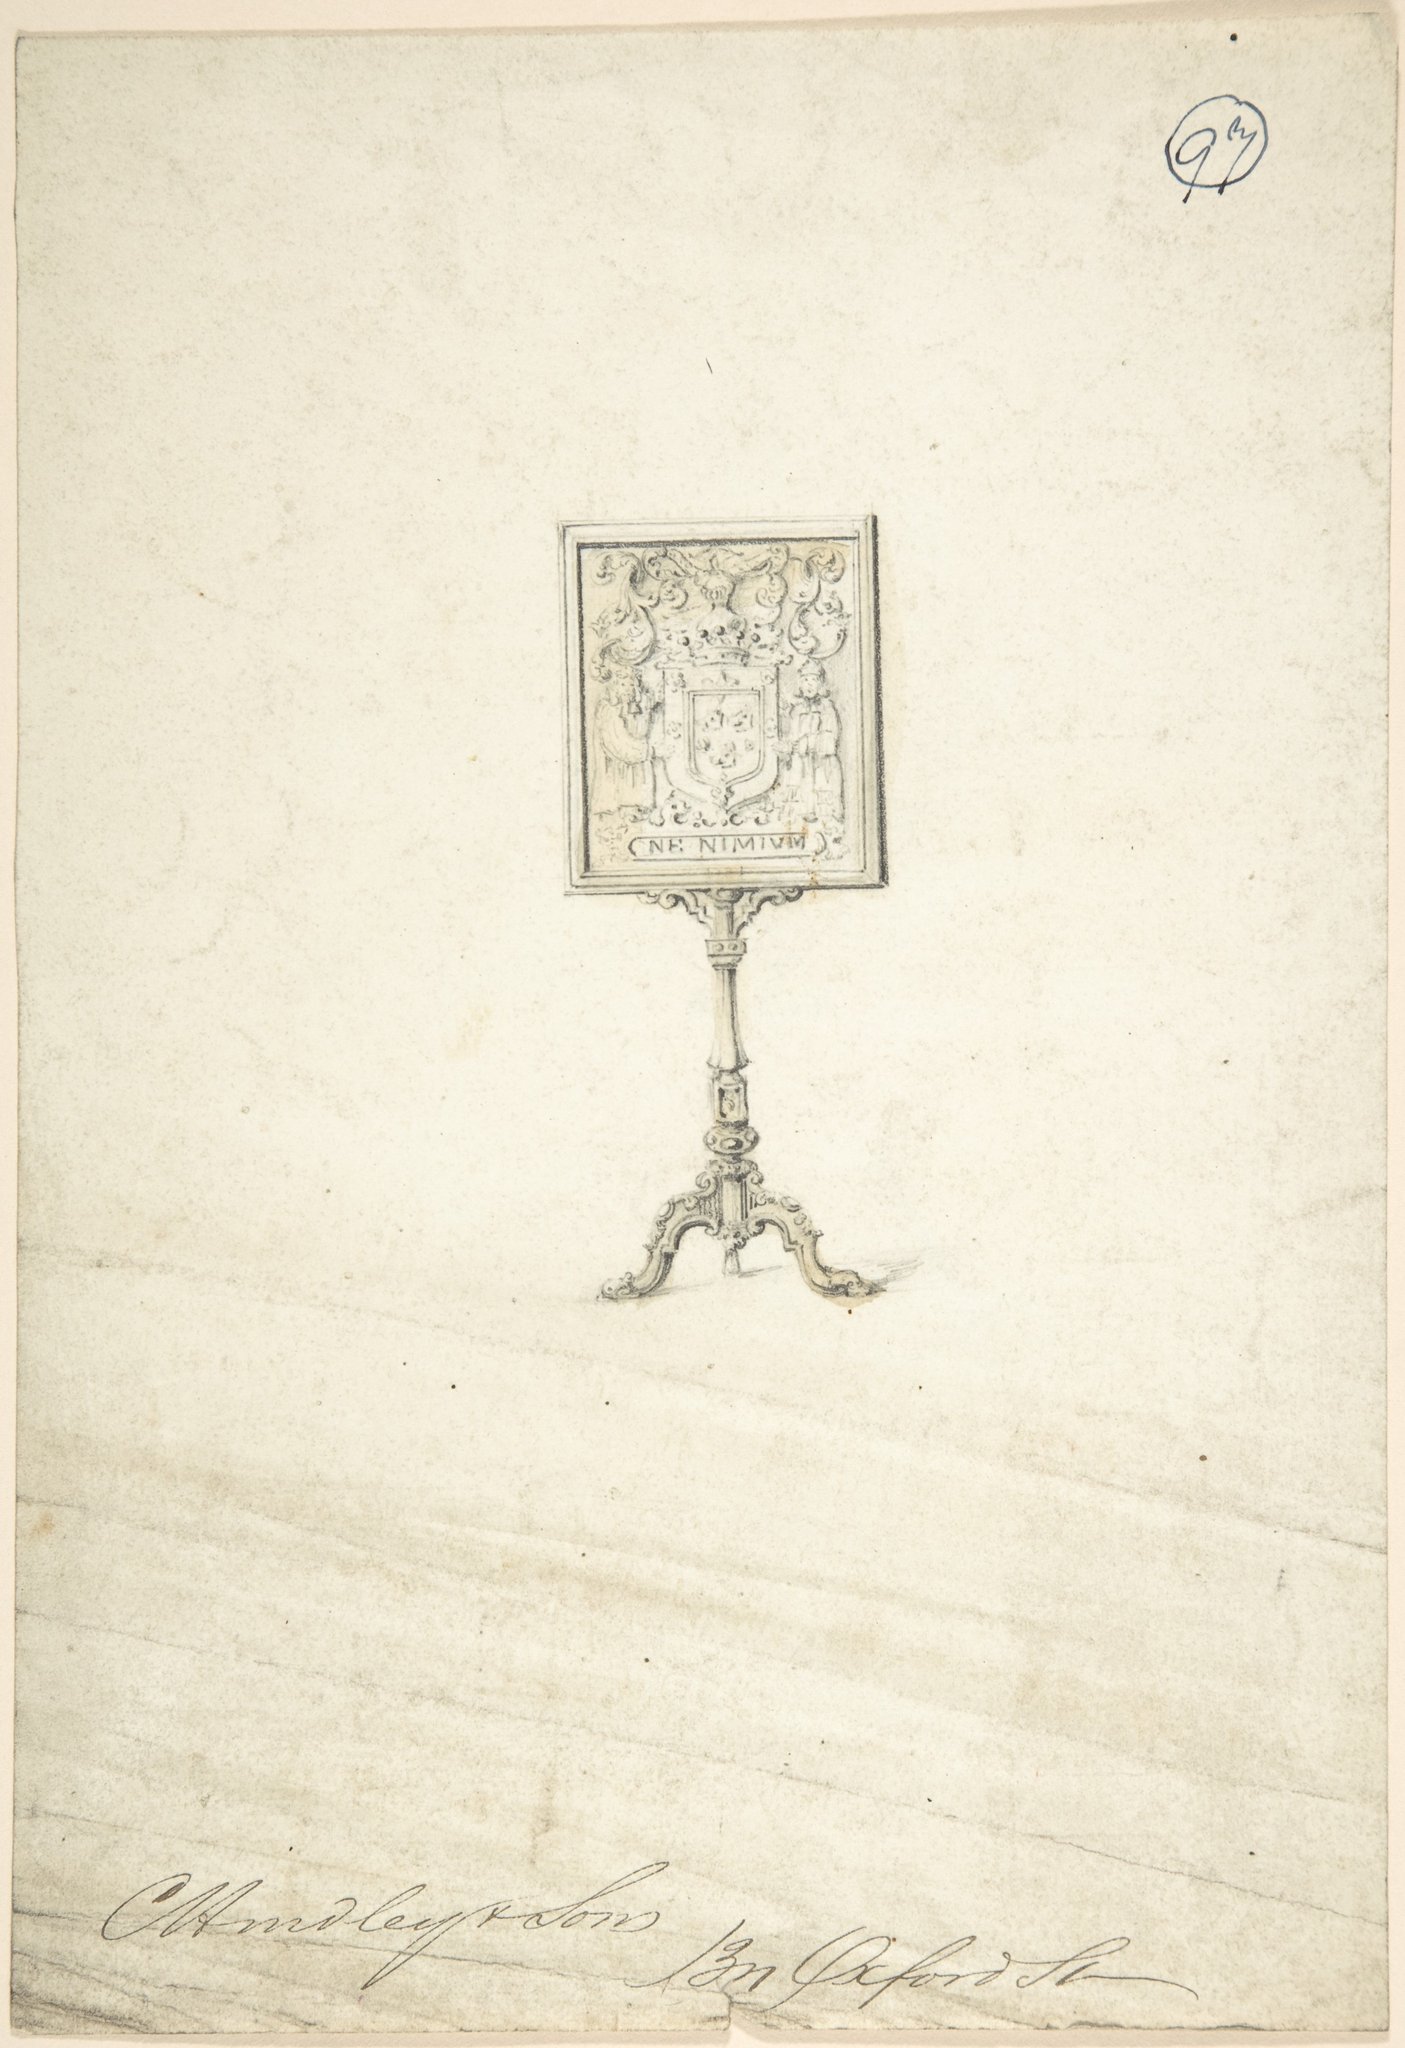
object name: drawing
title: Design for a Standing Frame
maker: charles hindley and sons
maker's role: artist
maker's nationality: british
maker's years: 1841-1917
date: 1841-1884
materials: ink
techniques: brush, pen, wash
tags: coat of arms